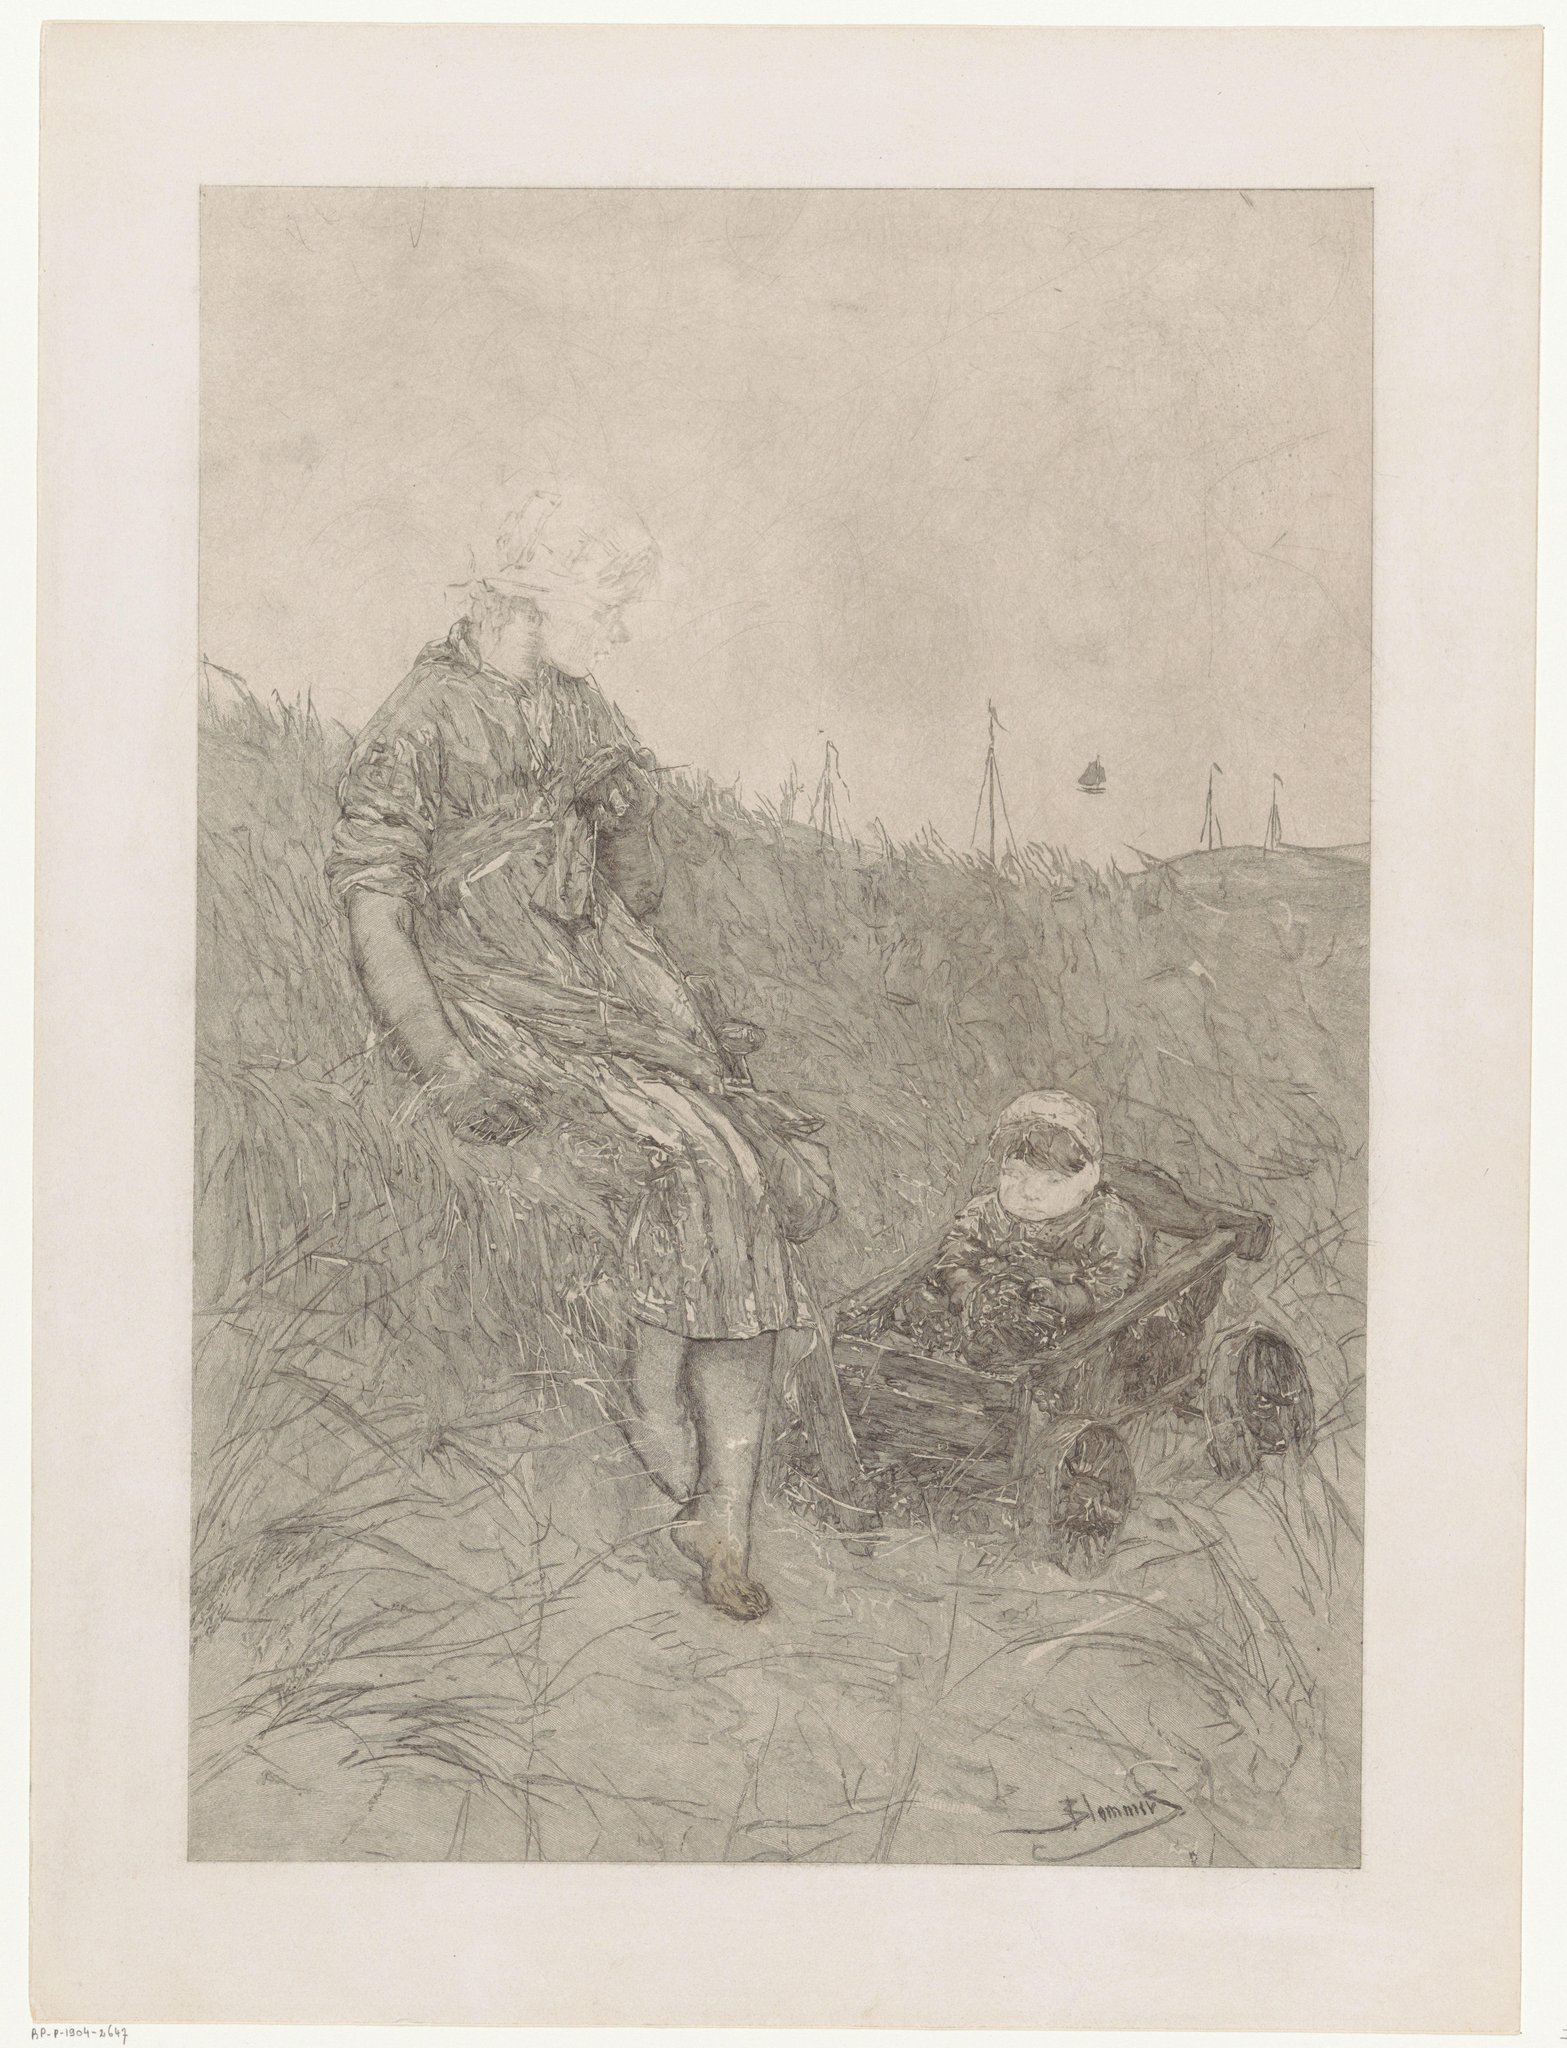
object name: print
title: Duinlandschap met een meisje en een jong kind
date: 1894-1904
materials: paper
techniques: etching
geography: netherlands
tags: baby-carriage, pram, perambulator, dune coast, knitting, sea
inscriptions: collector's mark: Lugt 2228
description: Duinlandschap met een breiend meisje en een jong kind in een houten wagen. Op de achtergrond enige scheepsmasten en de zee.